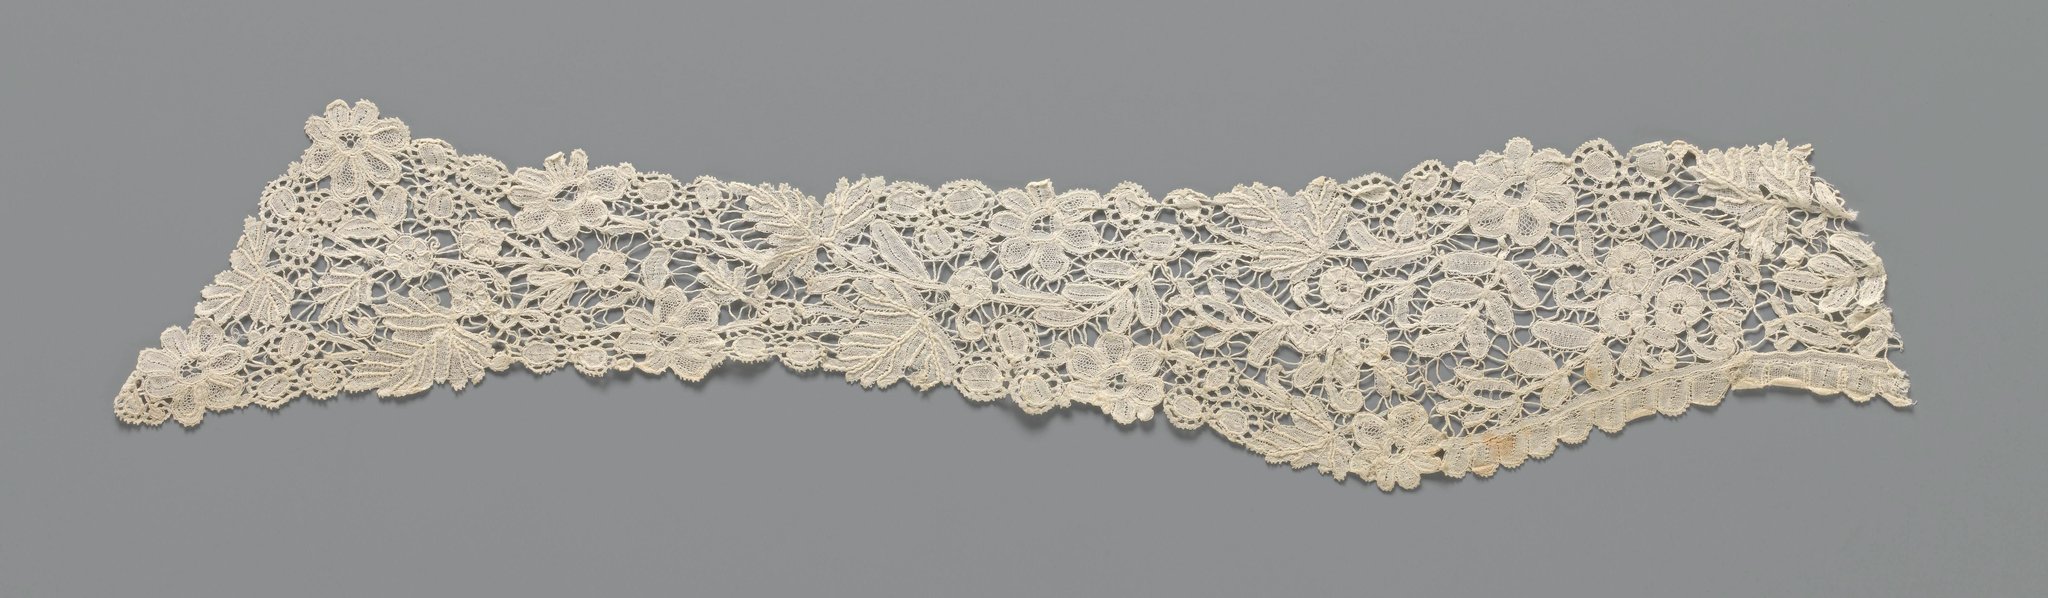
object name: womenswear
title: Sjaalkraag (helft) van kloskant met eikeblaadjes en rozen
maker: Anonymous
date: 1880-1910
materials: cotton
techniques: lace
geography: bruges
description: Sjaalkraag (helft) van naturelkleurig kloskant: Brugs bloemwerk. Rechthoekig model met één schuine kant en een versmalling en verbreding met een kleine knik erin. Patroon met verschillende soorten bloemen en bladeren, waaronder eikebladeren en rozen. De motieven zijn met elkaar verbonden door een vlechtengrond waarbij de vlechten als een traliegrond in zigzaglijnen is gelegd. De kraag is in het midden doorgeknipt.